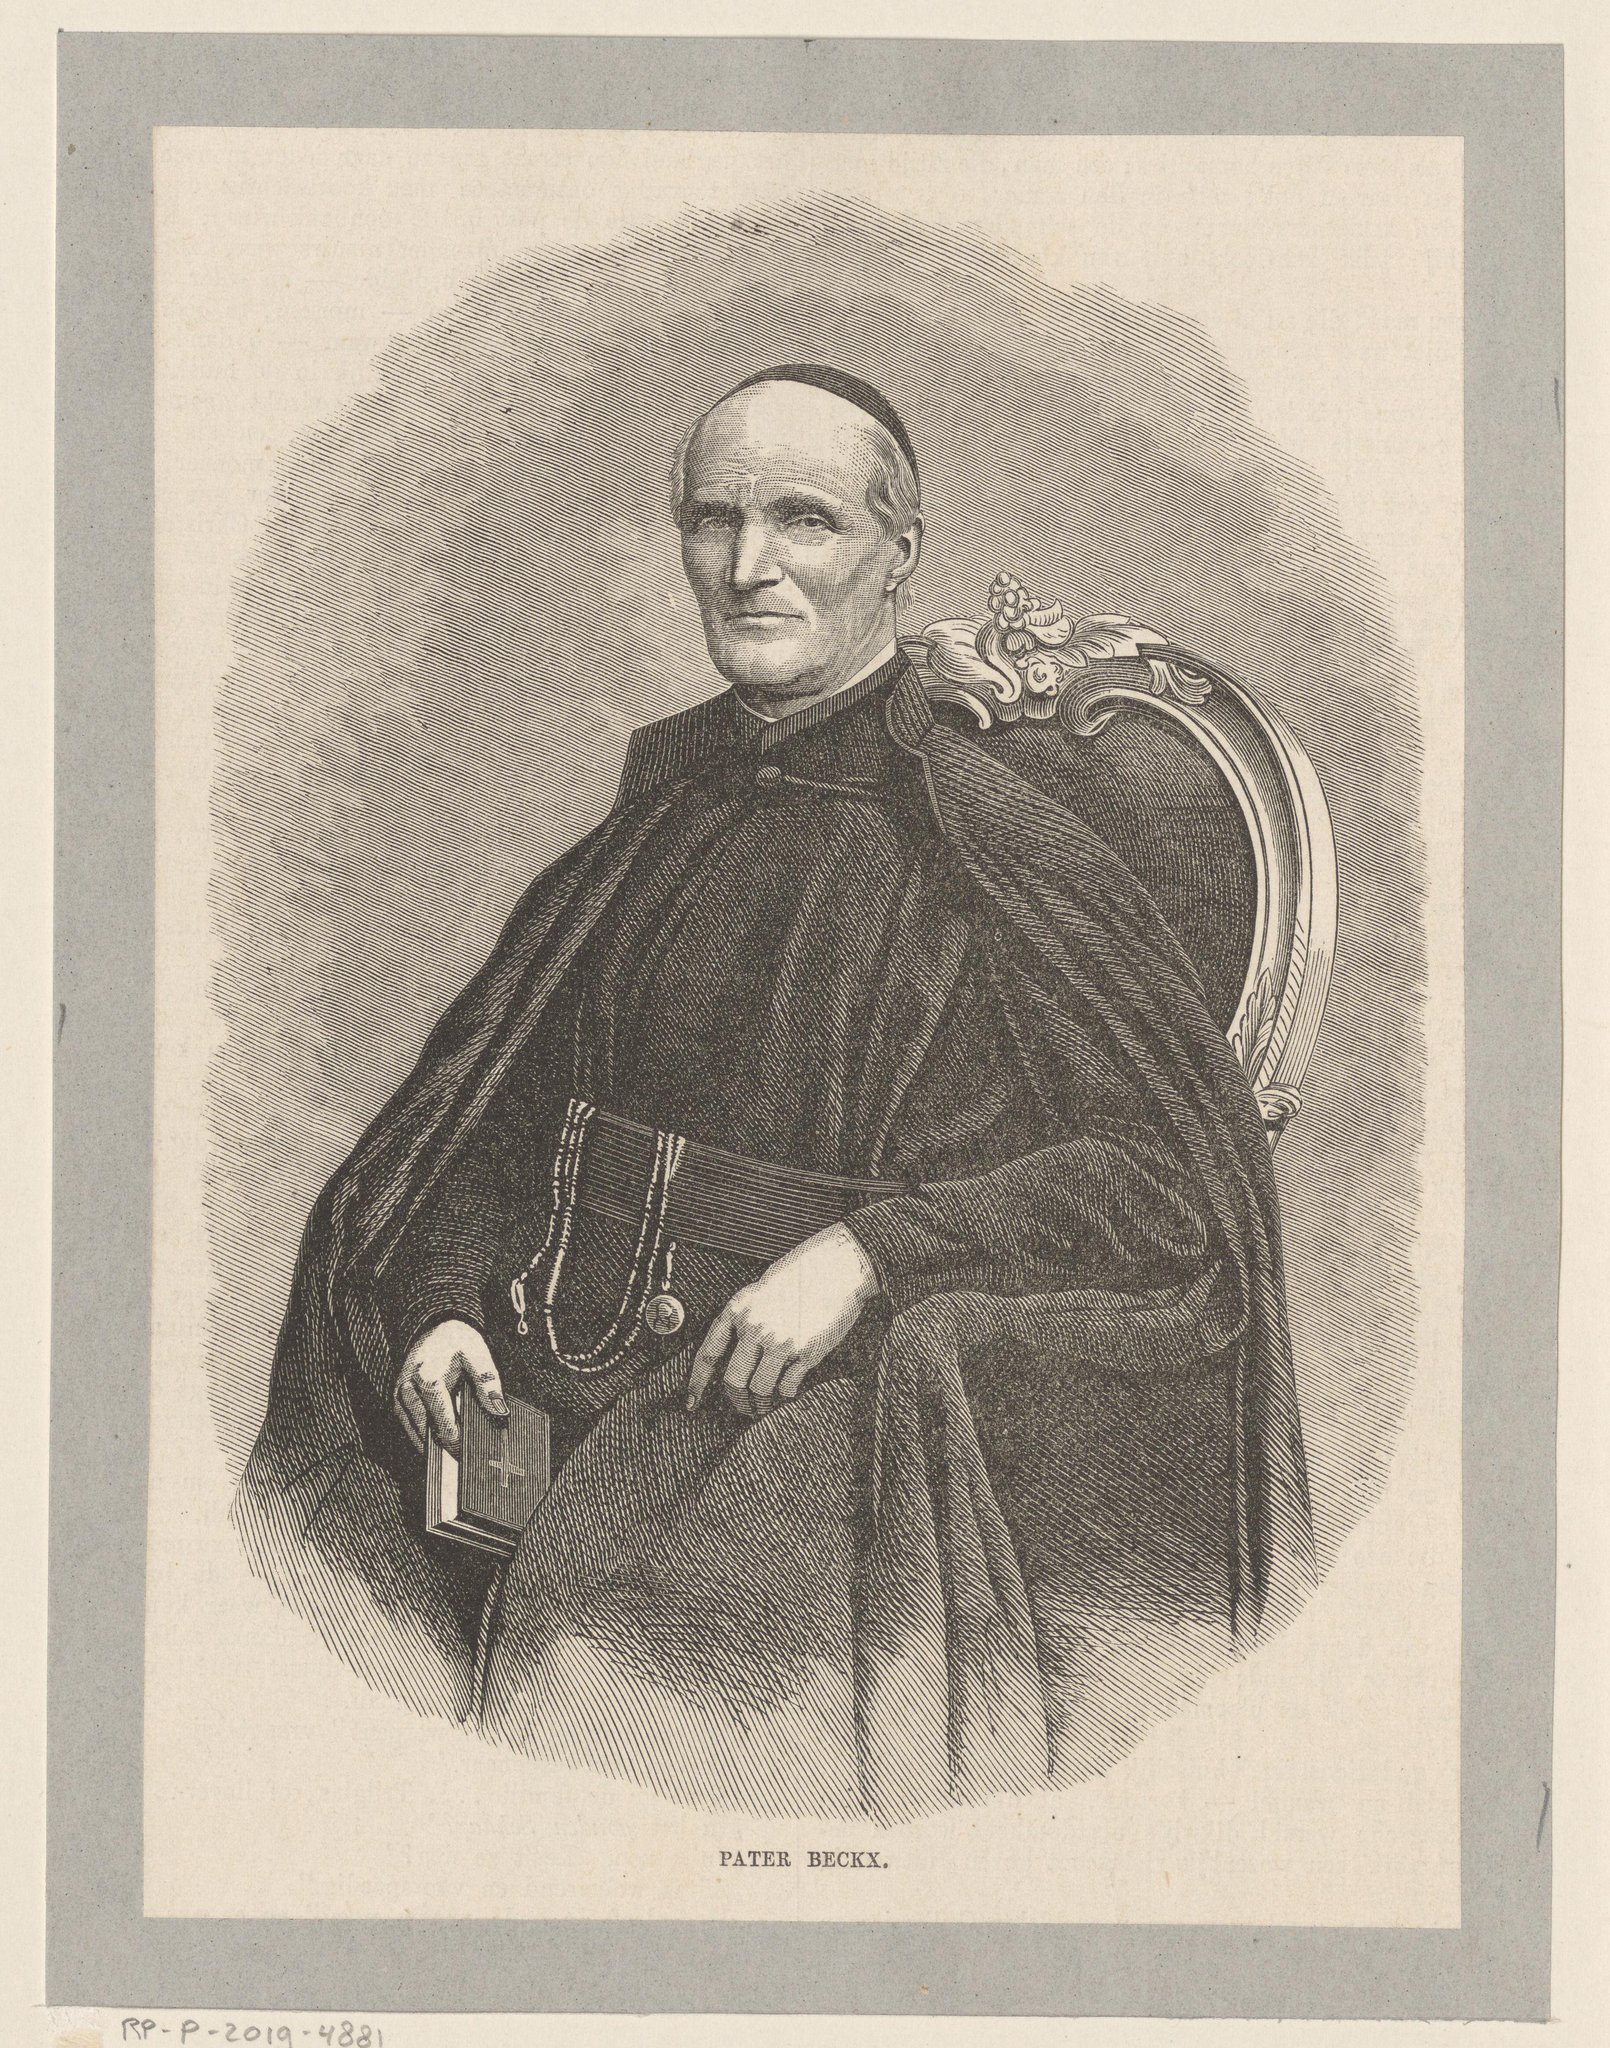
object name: print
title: Portret van Peter Jan Beckx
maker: Anonymous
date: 1850-1899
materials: paper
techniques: letterpress printing, engraving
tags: rome, priest, historical persons, book